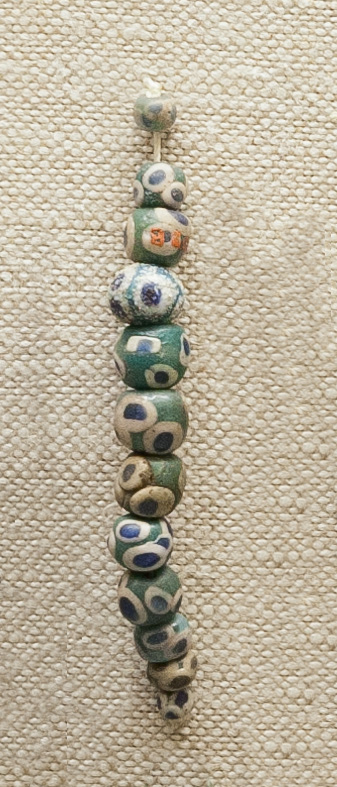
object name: necklace, bead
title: String of 12 Eyed Beads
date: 601-1000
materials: glass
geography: egypt